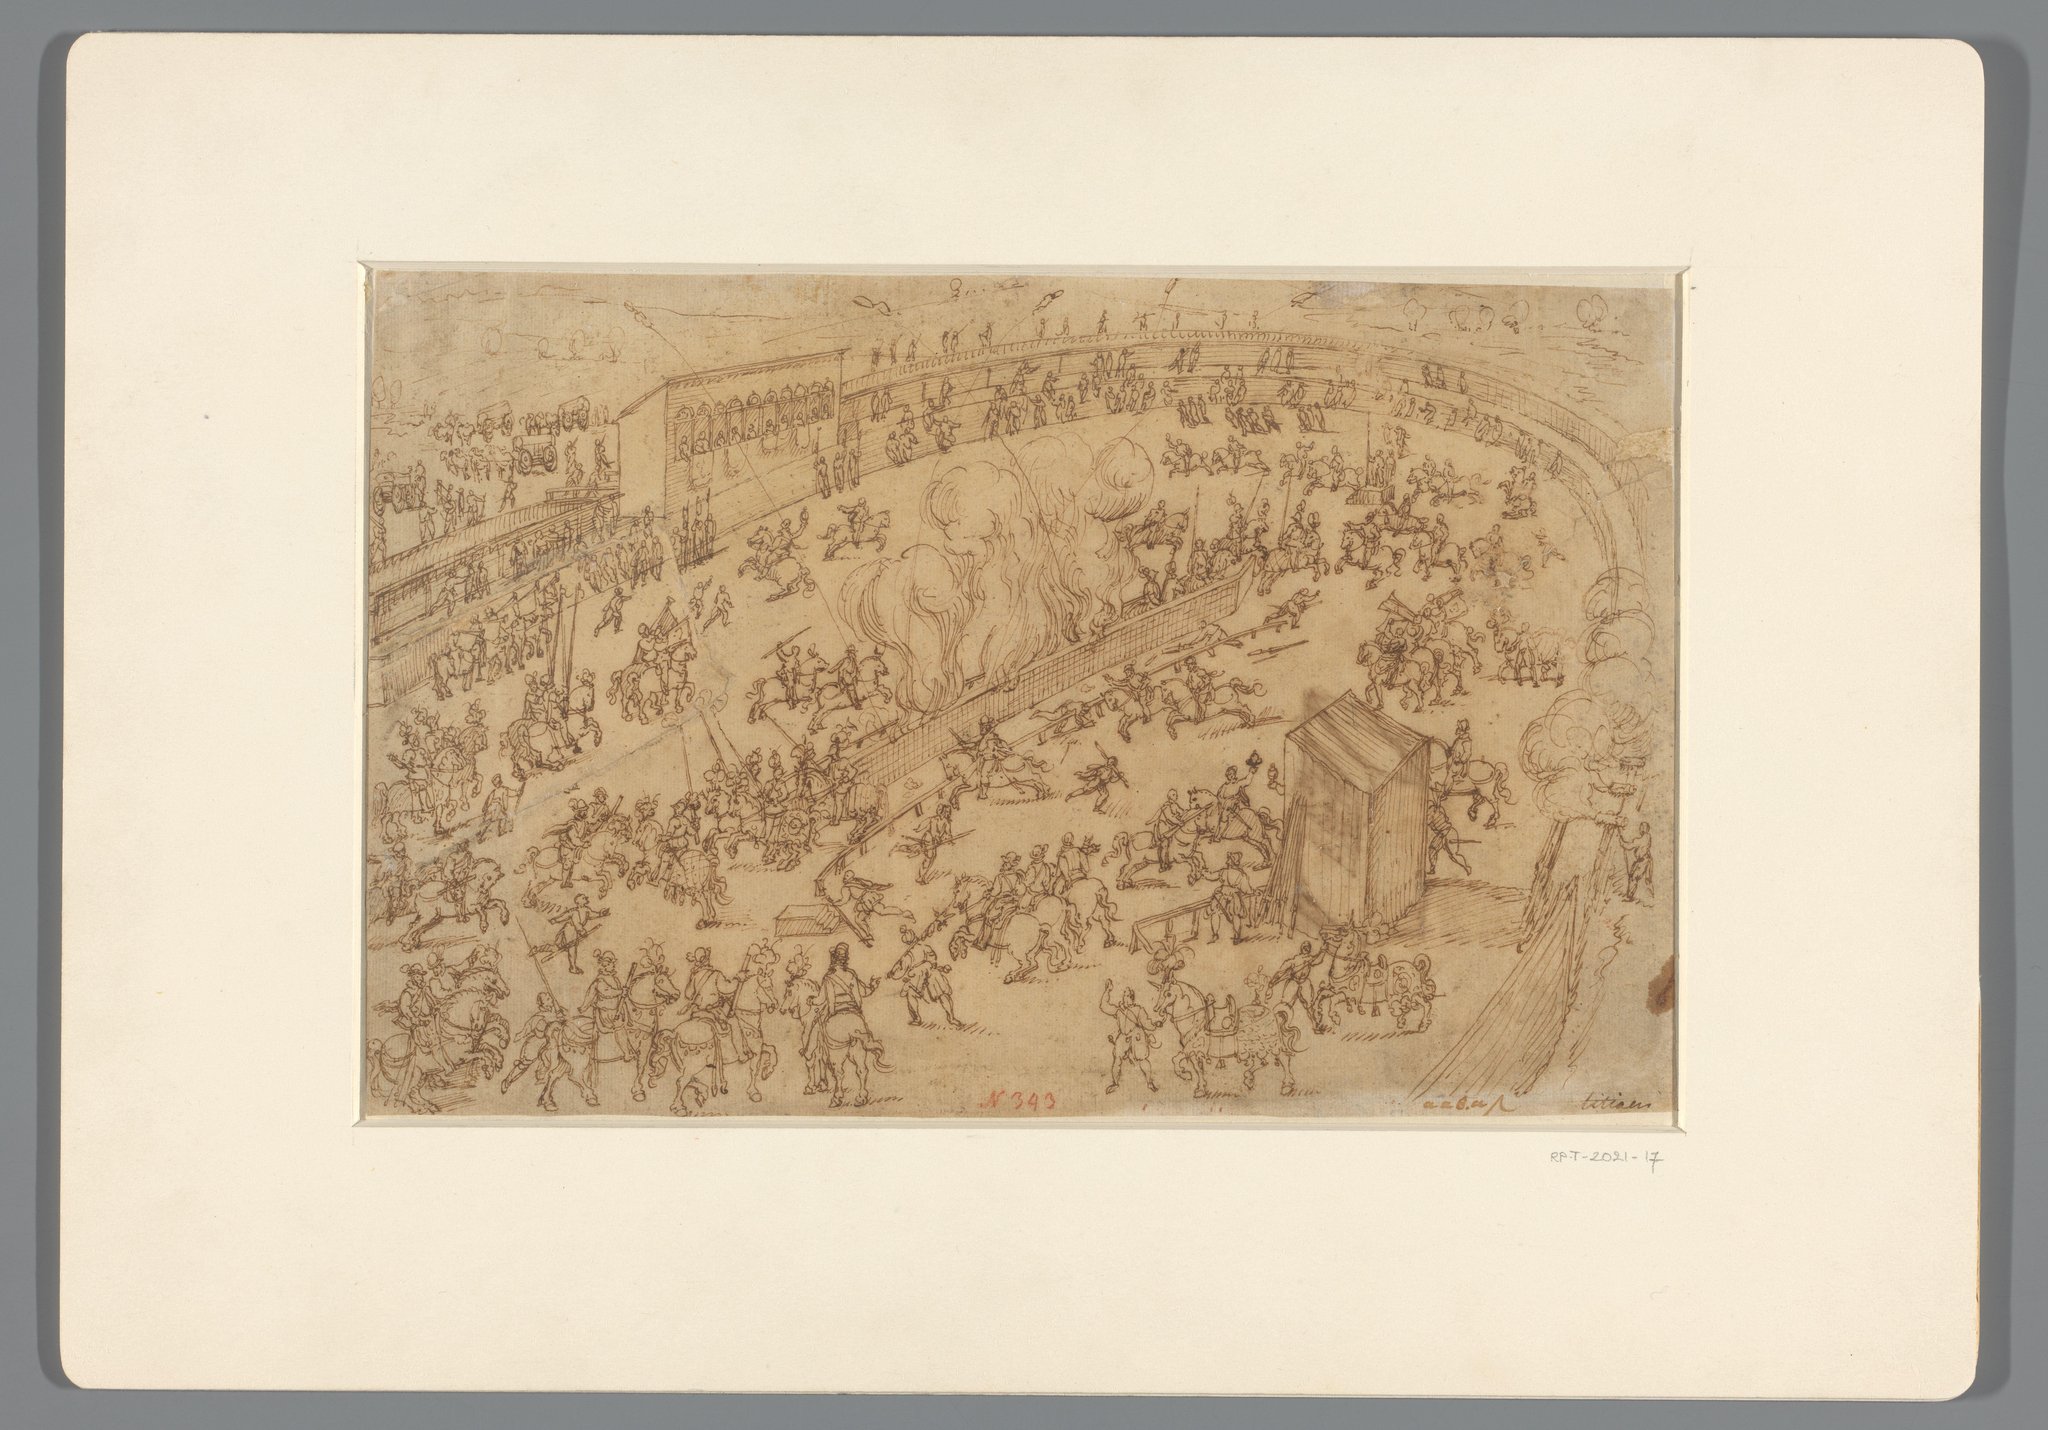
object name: drawing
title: A tournament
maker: Anonymous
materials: ink, paper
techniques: pen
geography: italy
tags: tournament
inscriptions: inscription, lower right corner, brown ink: ‘titian’, number, lower centre, red pencil: ‘N 343’, inscription, lower right corner, brown ink: ‘aaB/a^’, watermark: Briquet 224